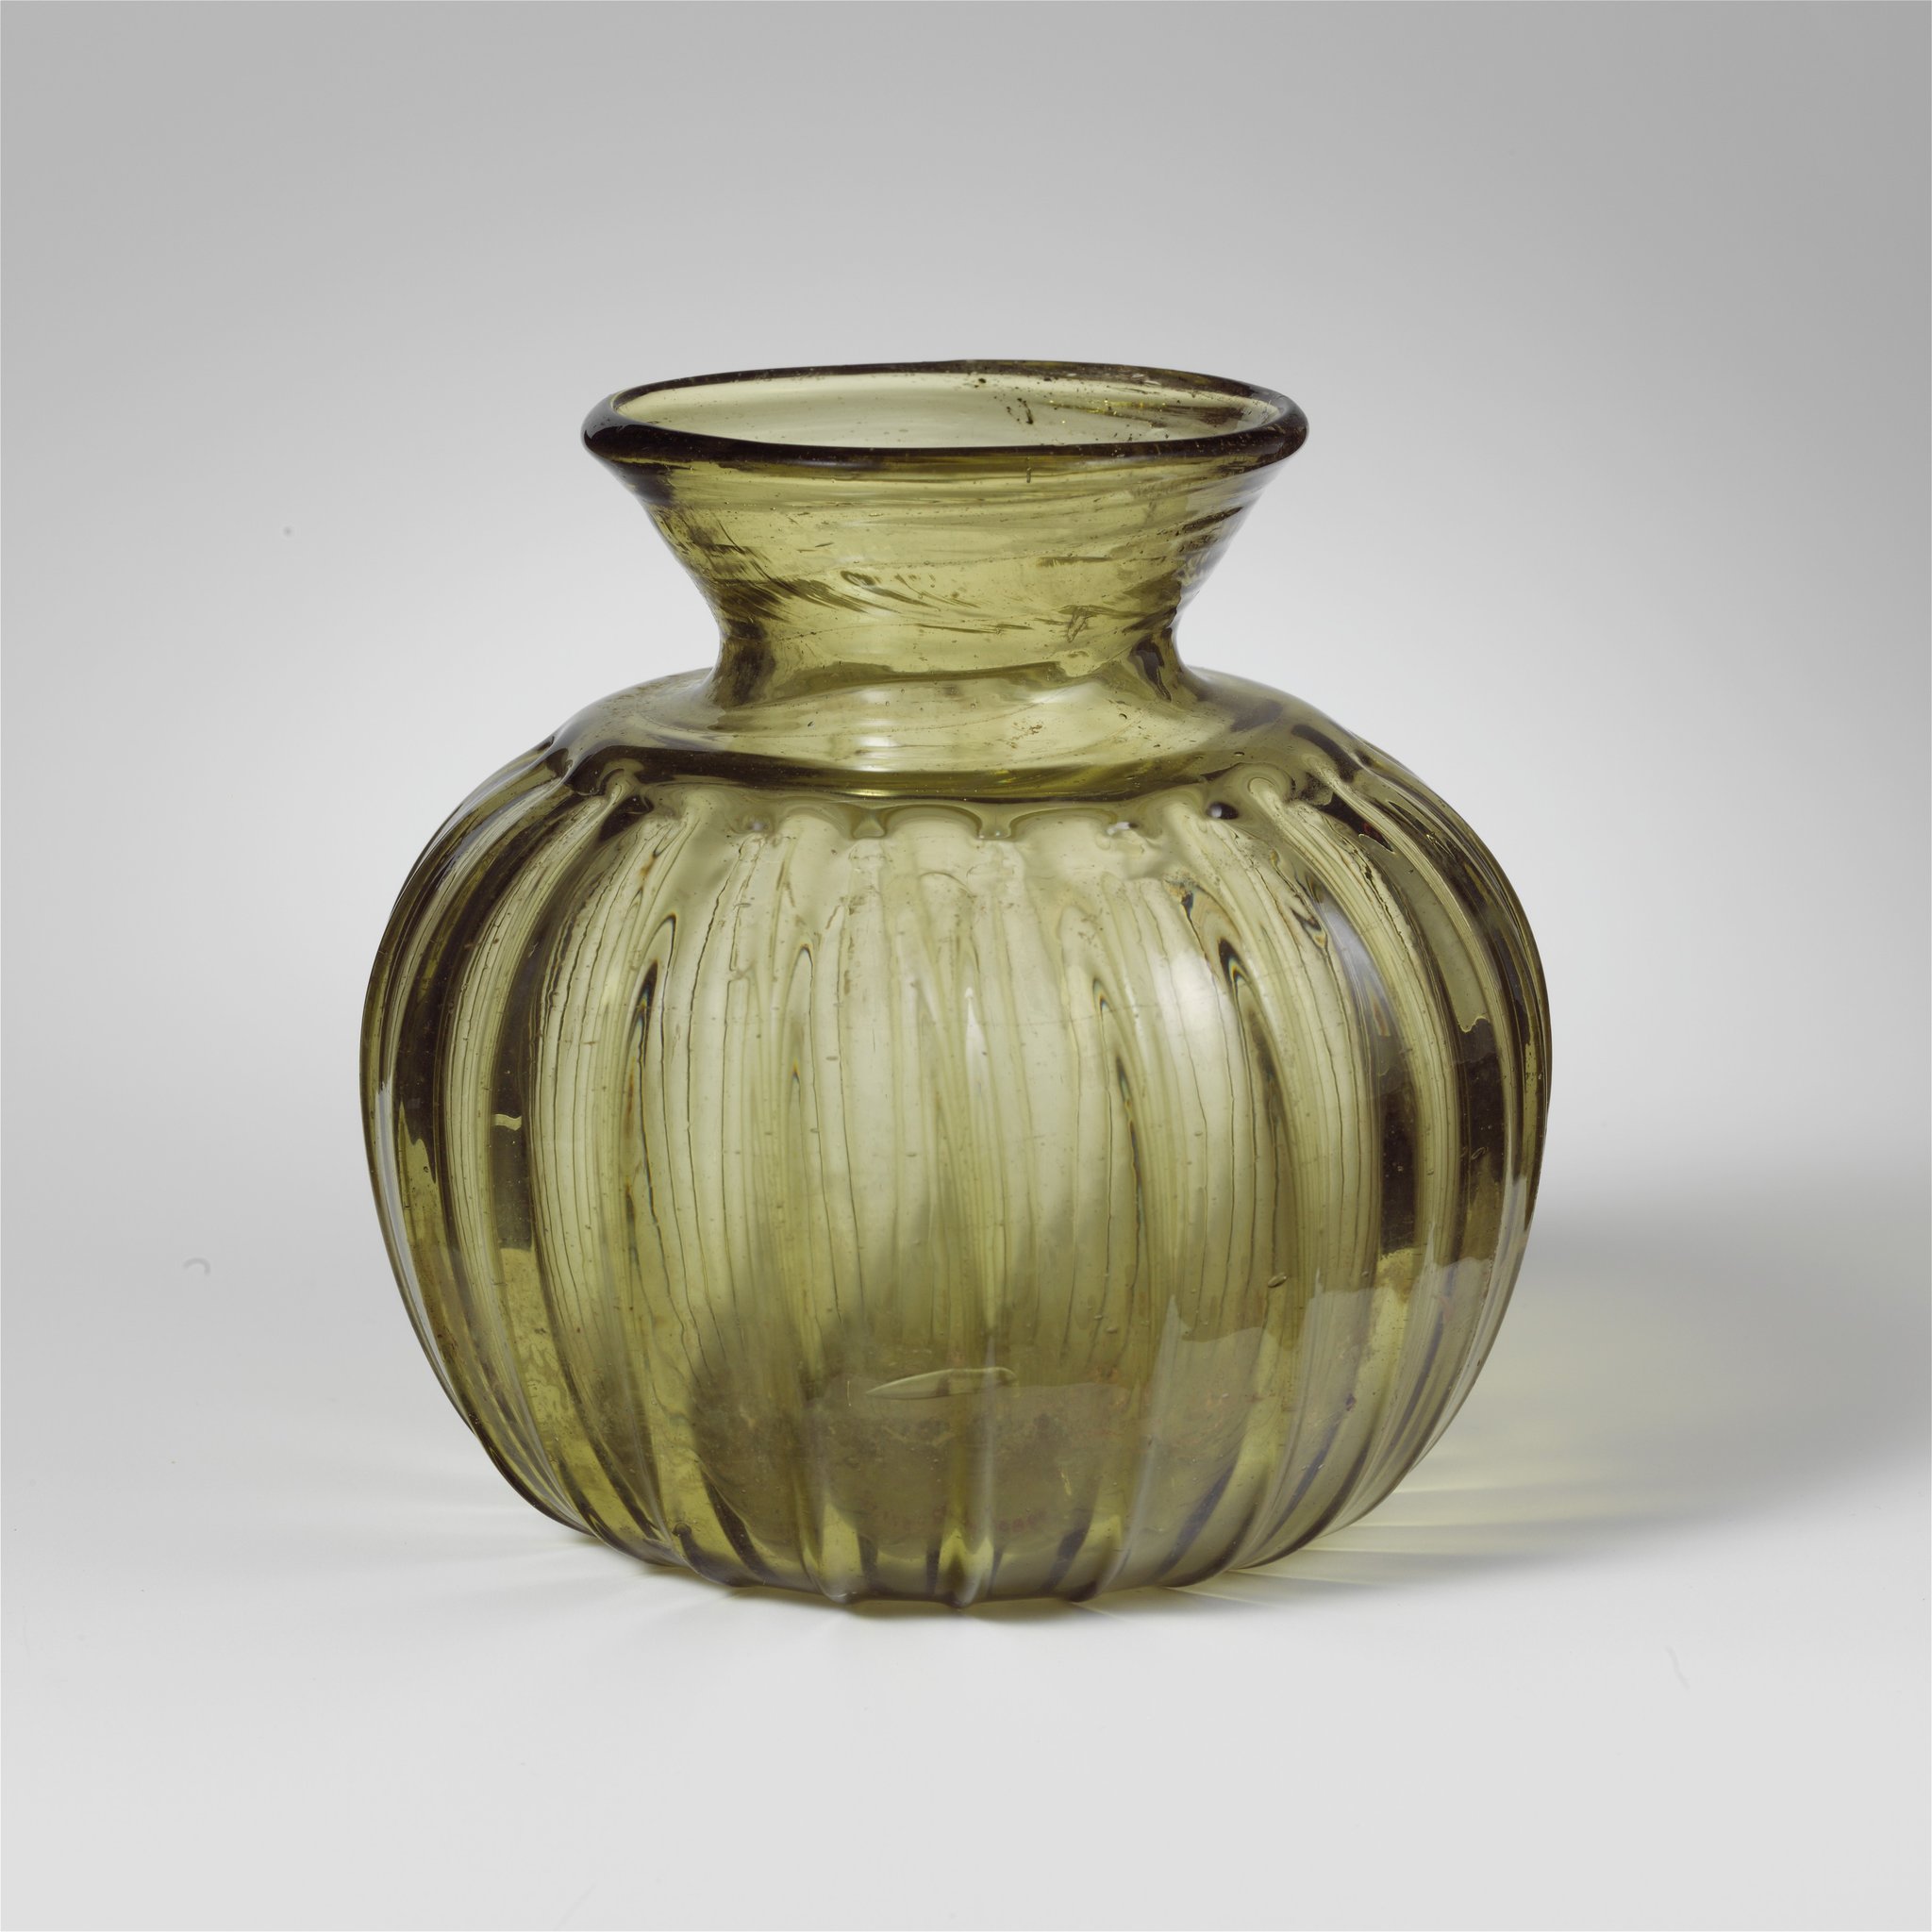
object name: jar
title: Glass jar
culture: roman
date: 201-400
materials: glass